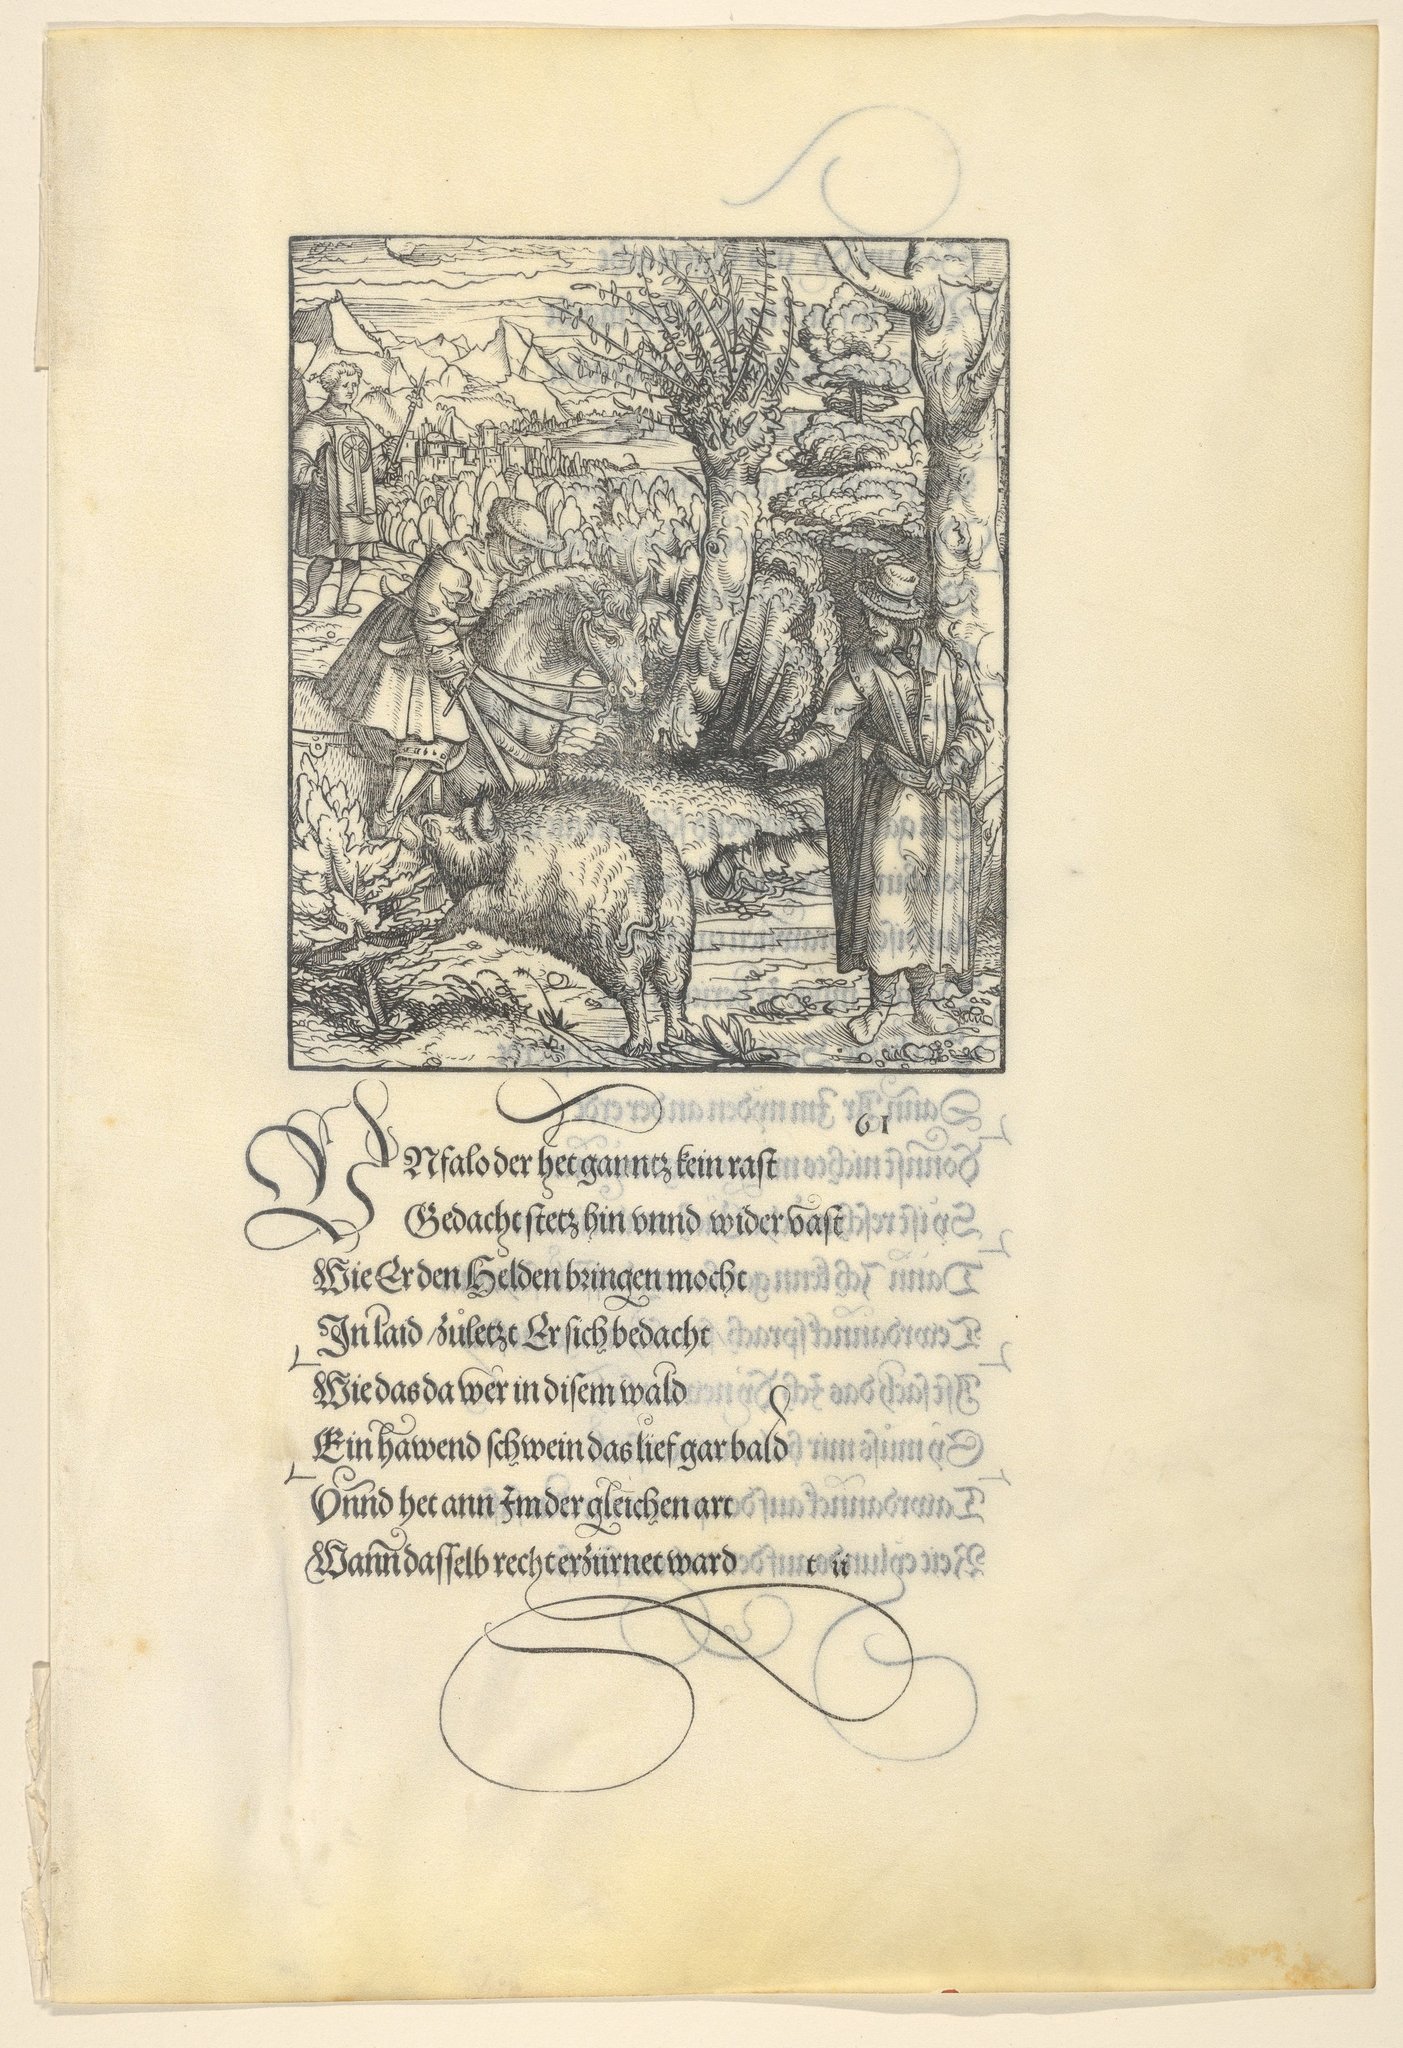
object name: print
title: Theuerdarnk on a Boar Hunt, from [Theuerdank] Die geuerlicheiten vnd einsteils der geschichten des loblichen streytparen vnd hochberümbten helds vnd Ritters herr Tewrdannckhs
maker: hans burgkmair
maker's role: artist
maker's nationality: german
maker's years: 1473-1531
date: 1517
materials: parchment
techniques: woodcut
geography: germany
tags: buildings,men,hunting,boars,horses